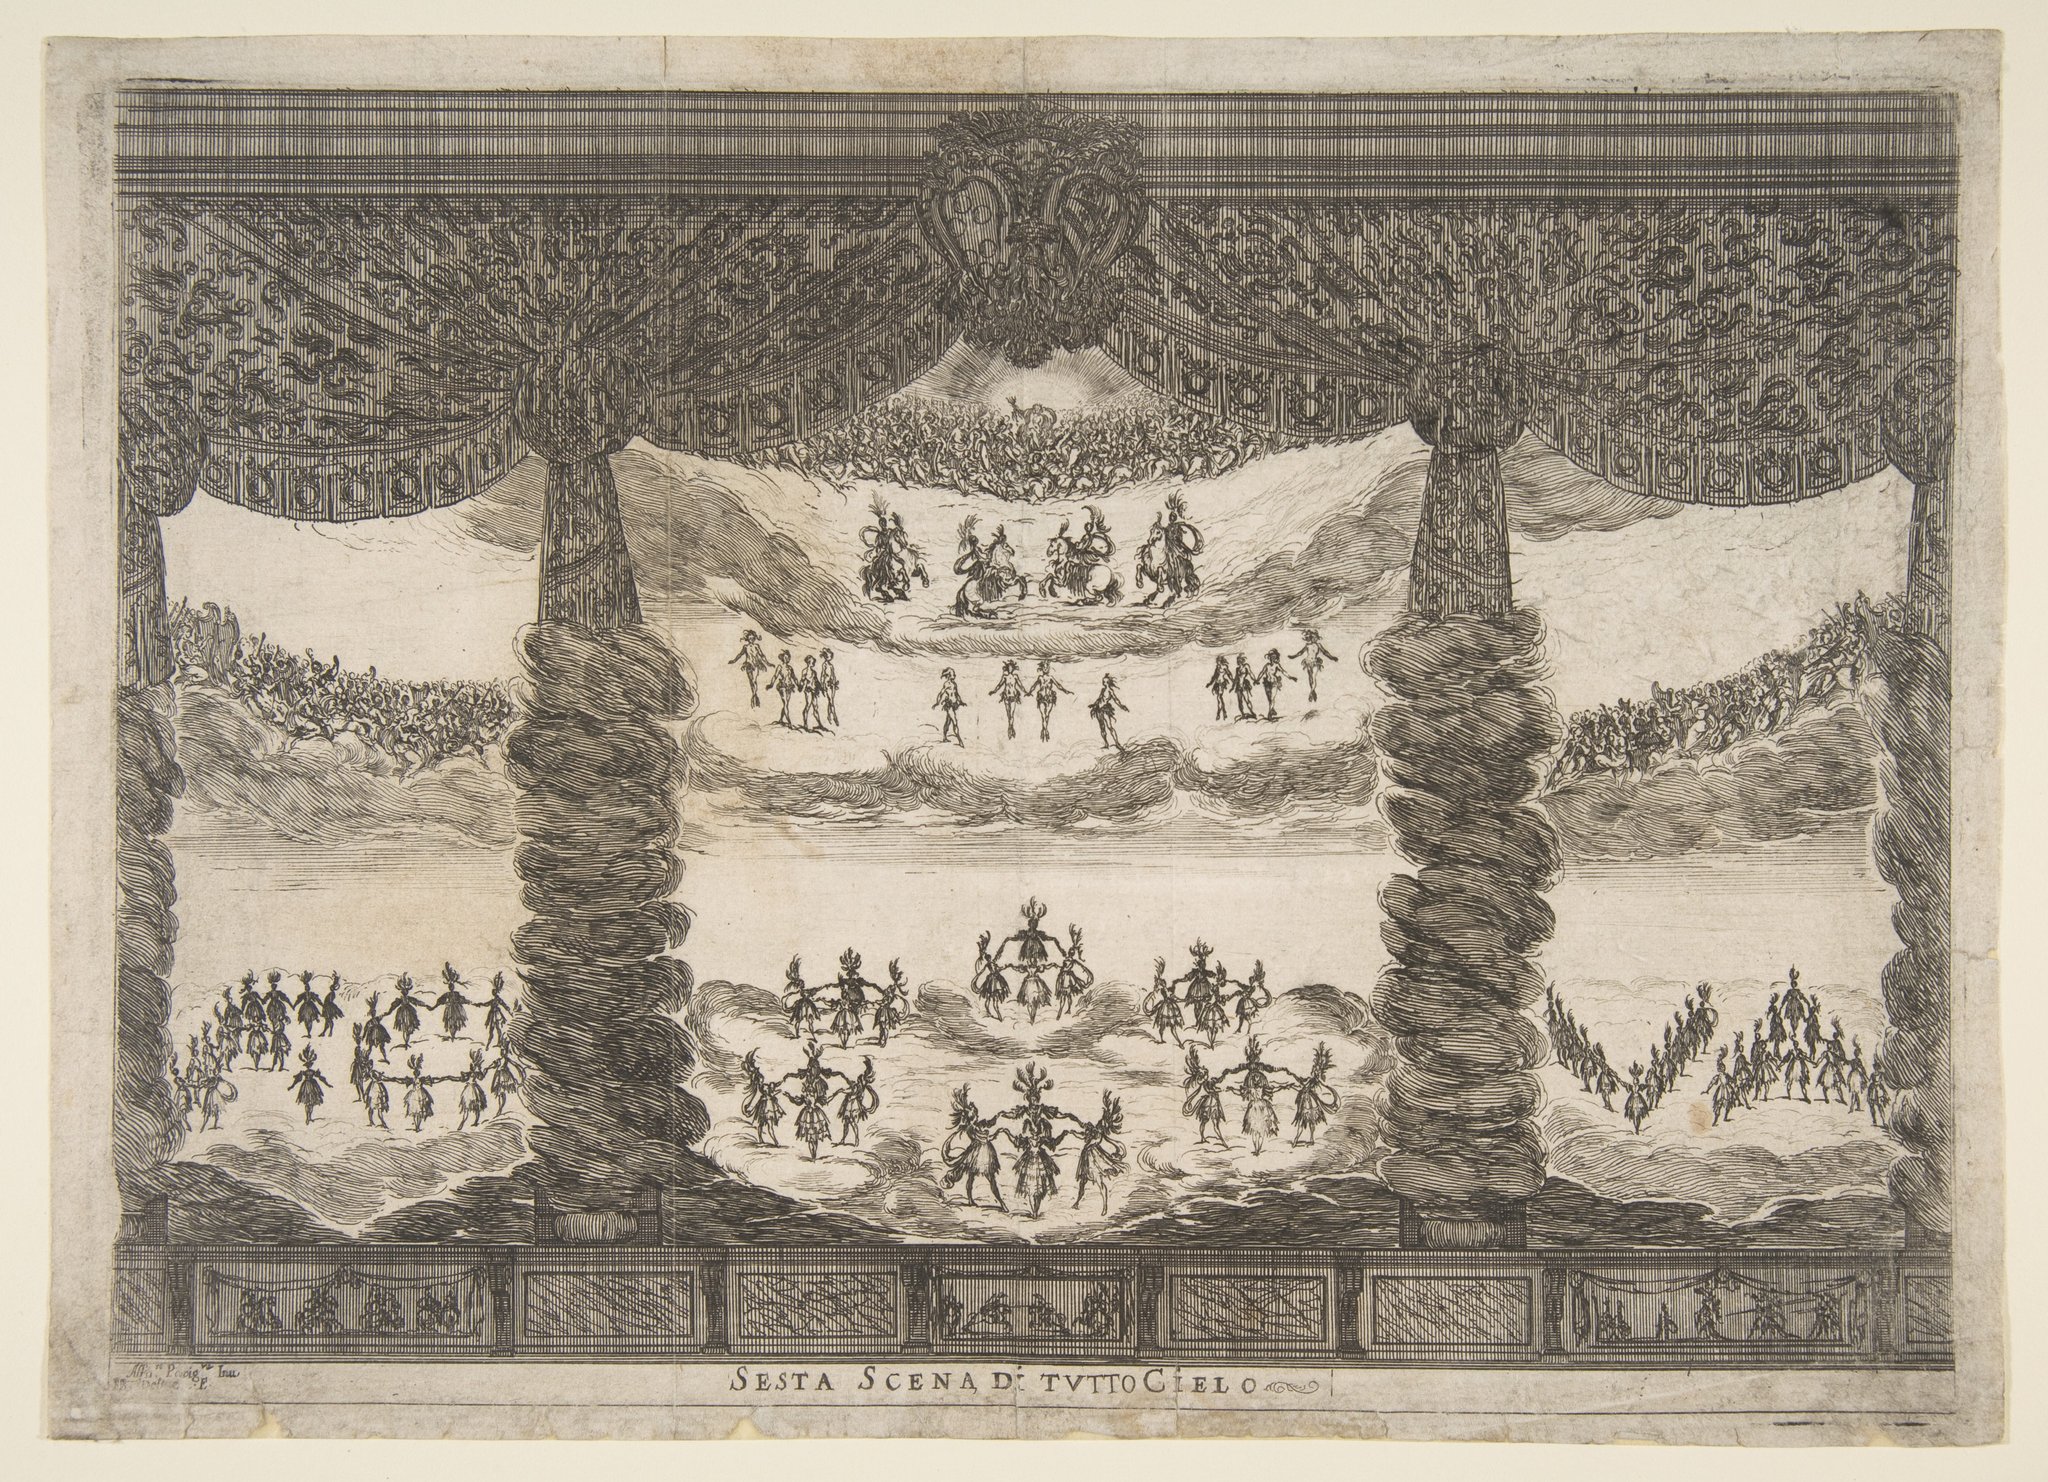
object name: print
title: Sixth scene, the heavens, from "The marriage of the gods" (Le nozze degli Dei)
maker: stefano della bella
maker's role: artist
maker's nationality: italian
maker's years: 1610-1664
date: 1637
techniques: etching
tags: heaven